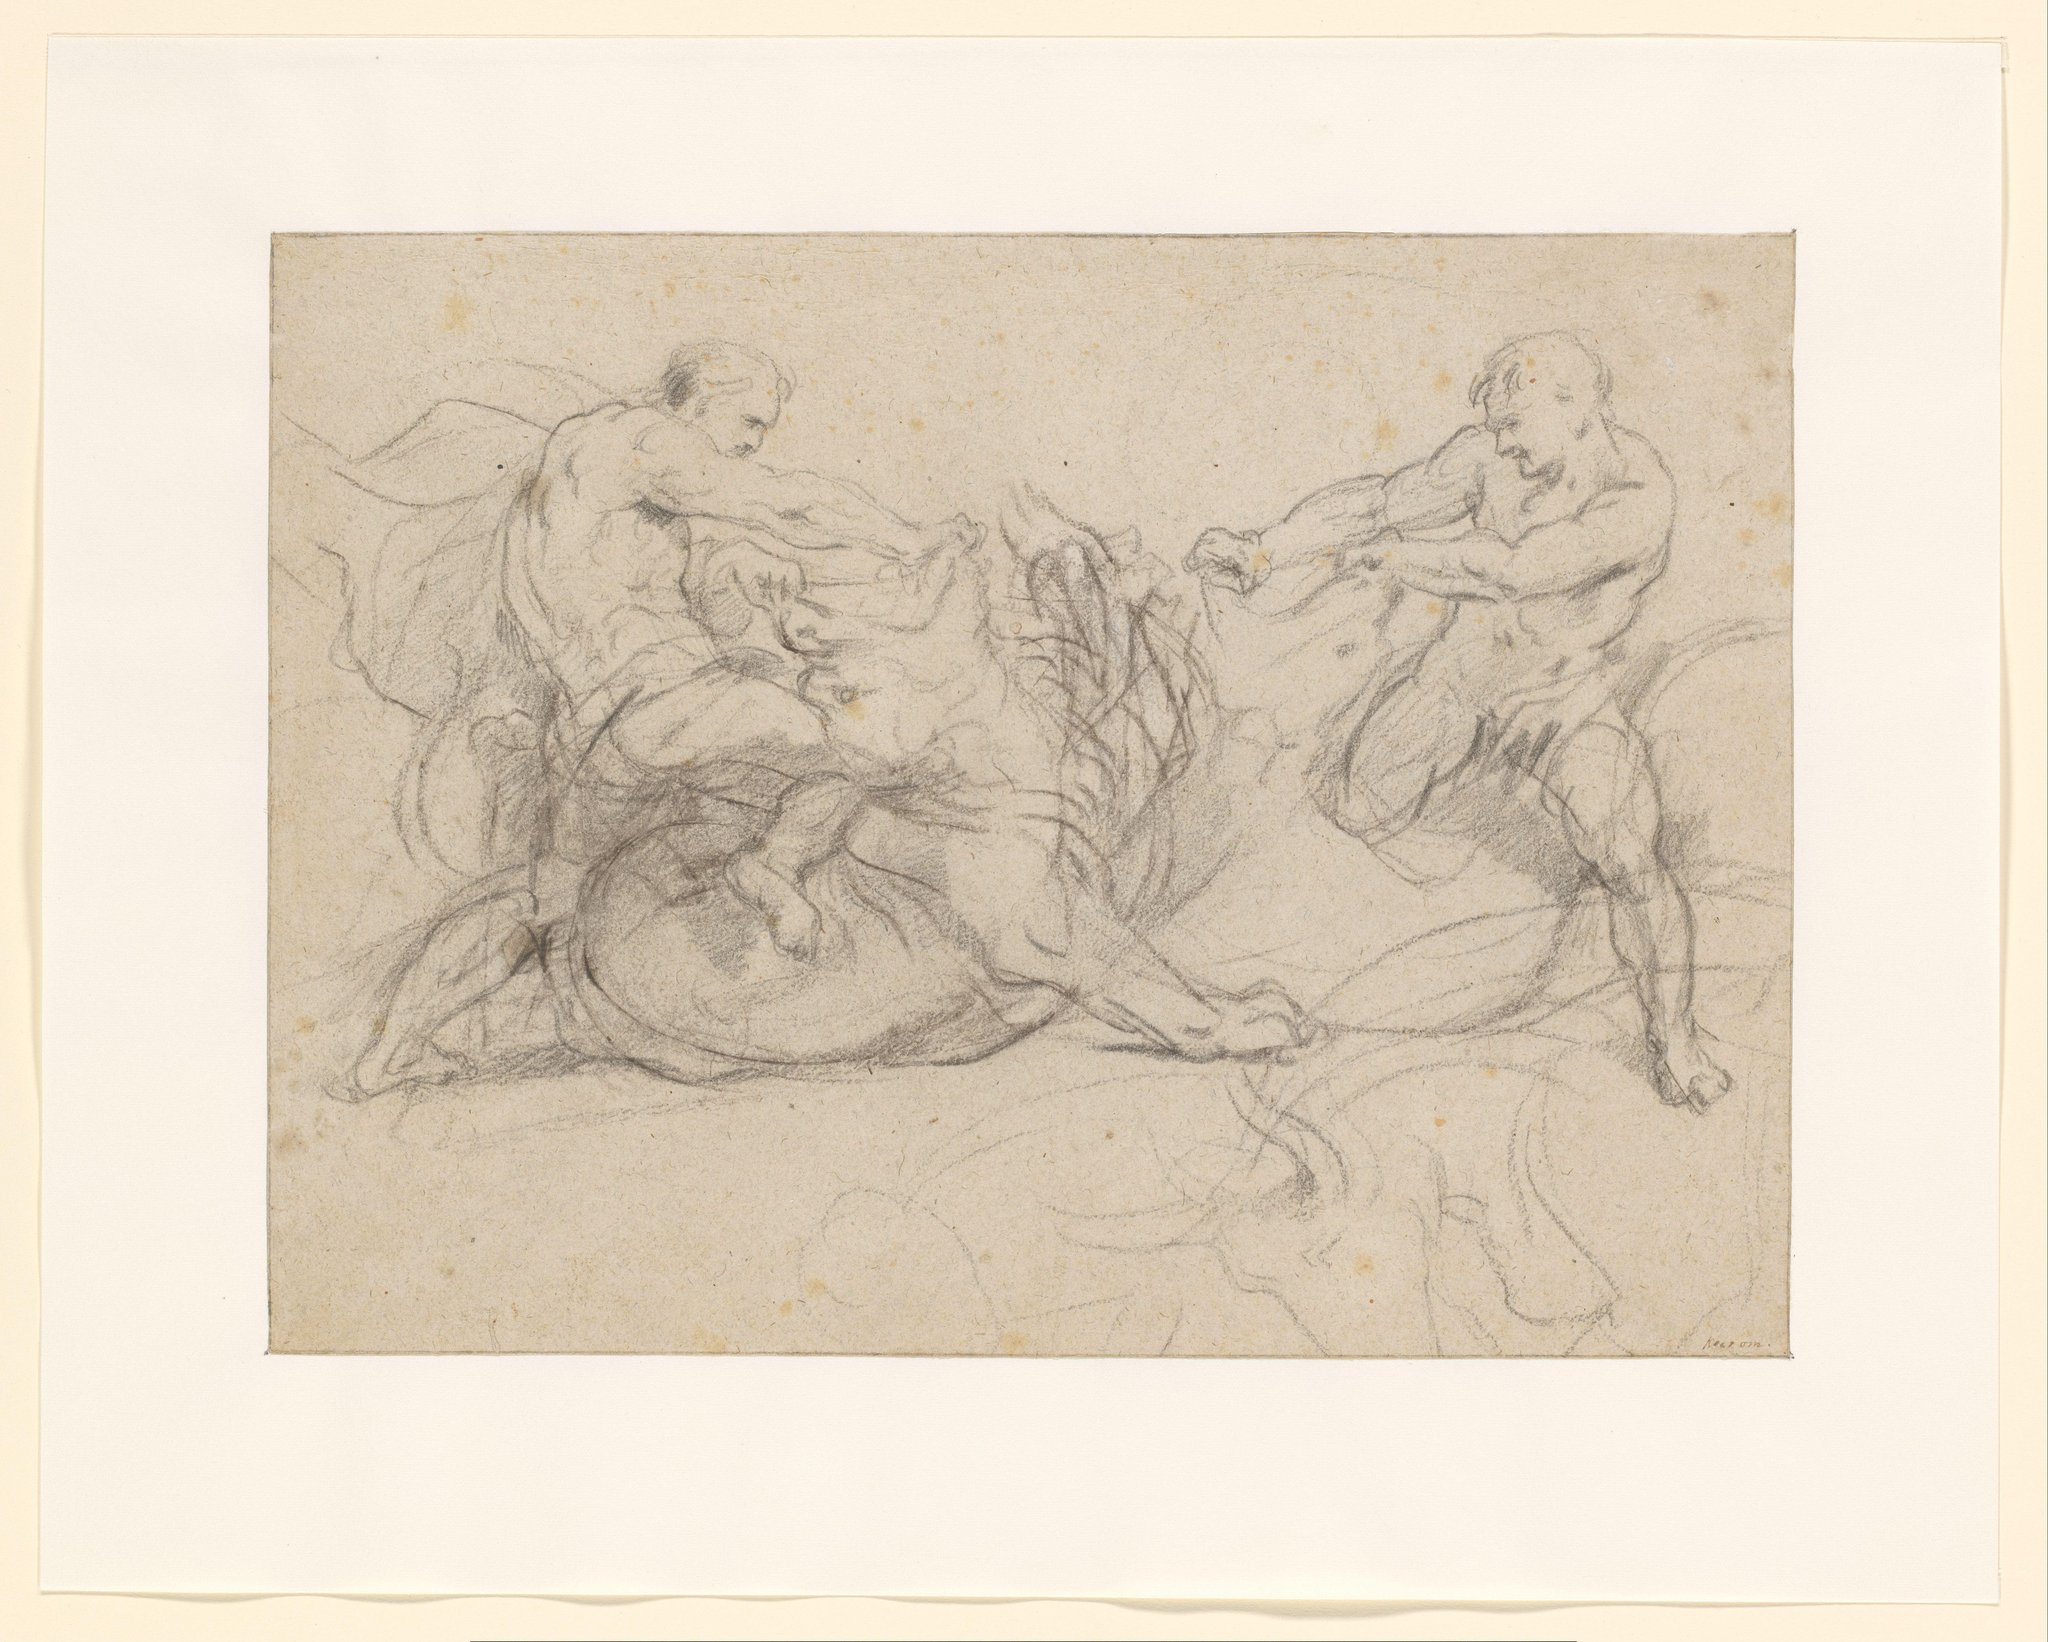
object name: drawing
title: Samson vechtend met de leeuw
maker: peter paul rubens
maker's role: draughtsman, painter, print maker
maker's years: 1577-1640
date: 1587-1640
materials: chalk, paper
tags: samson kills the lion with his bare hands